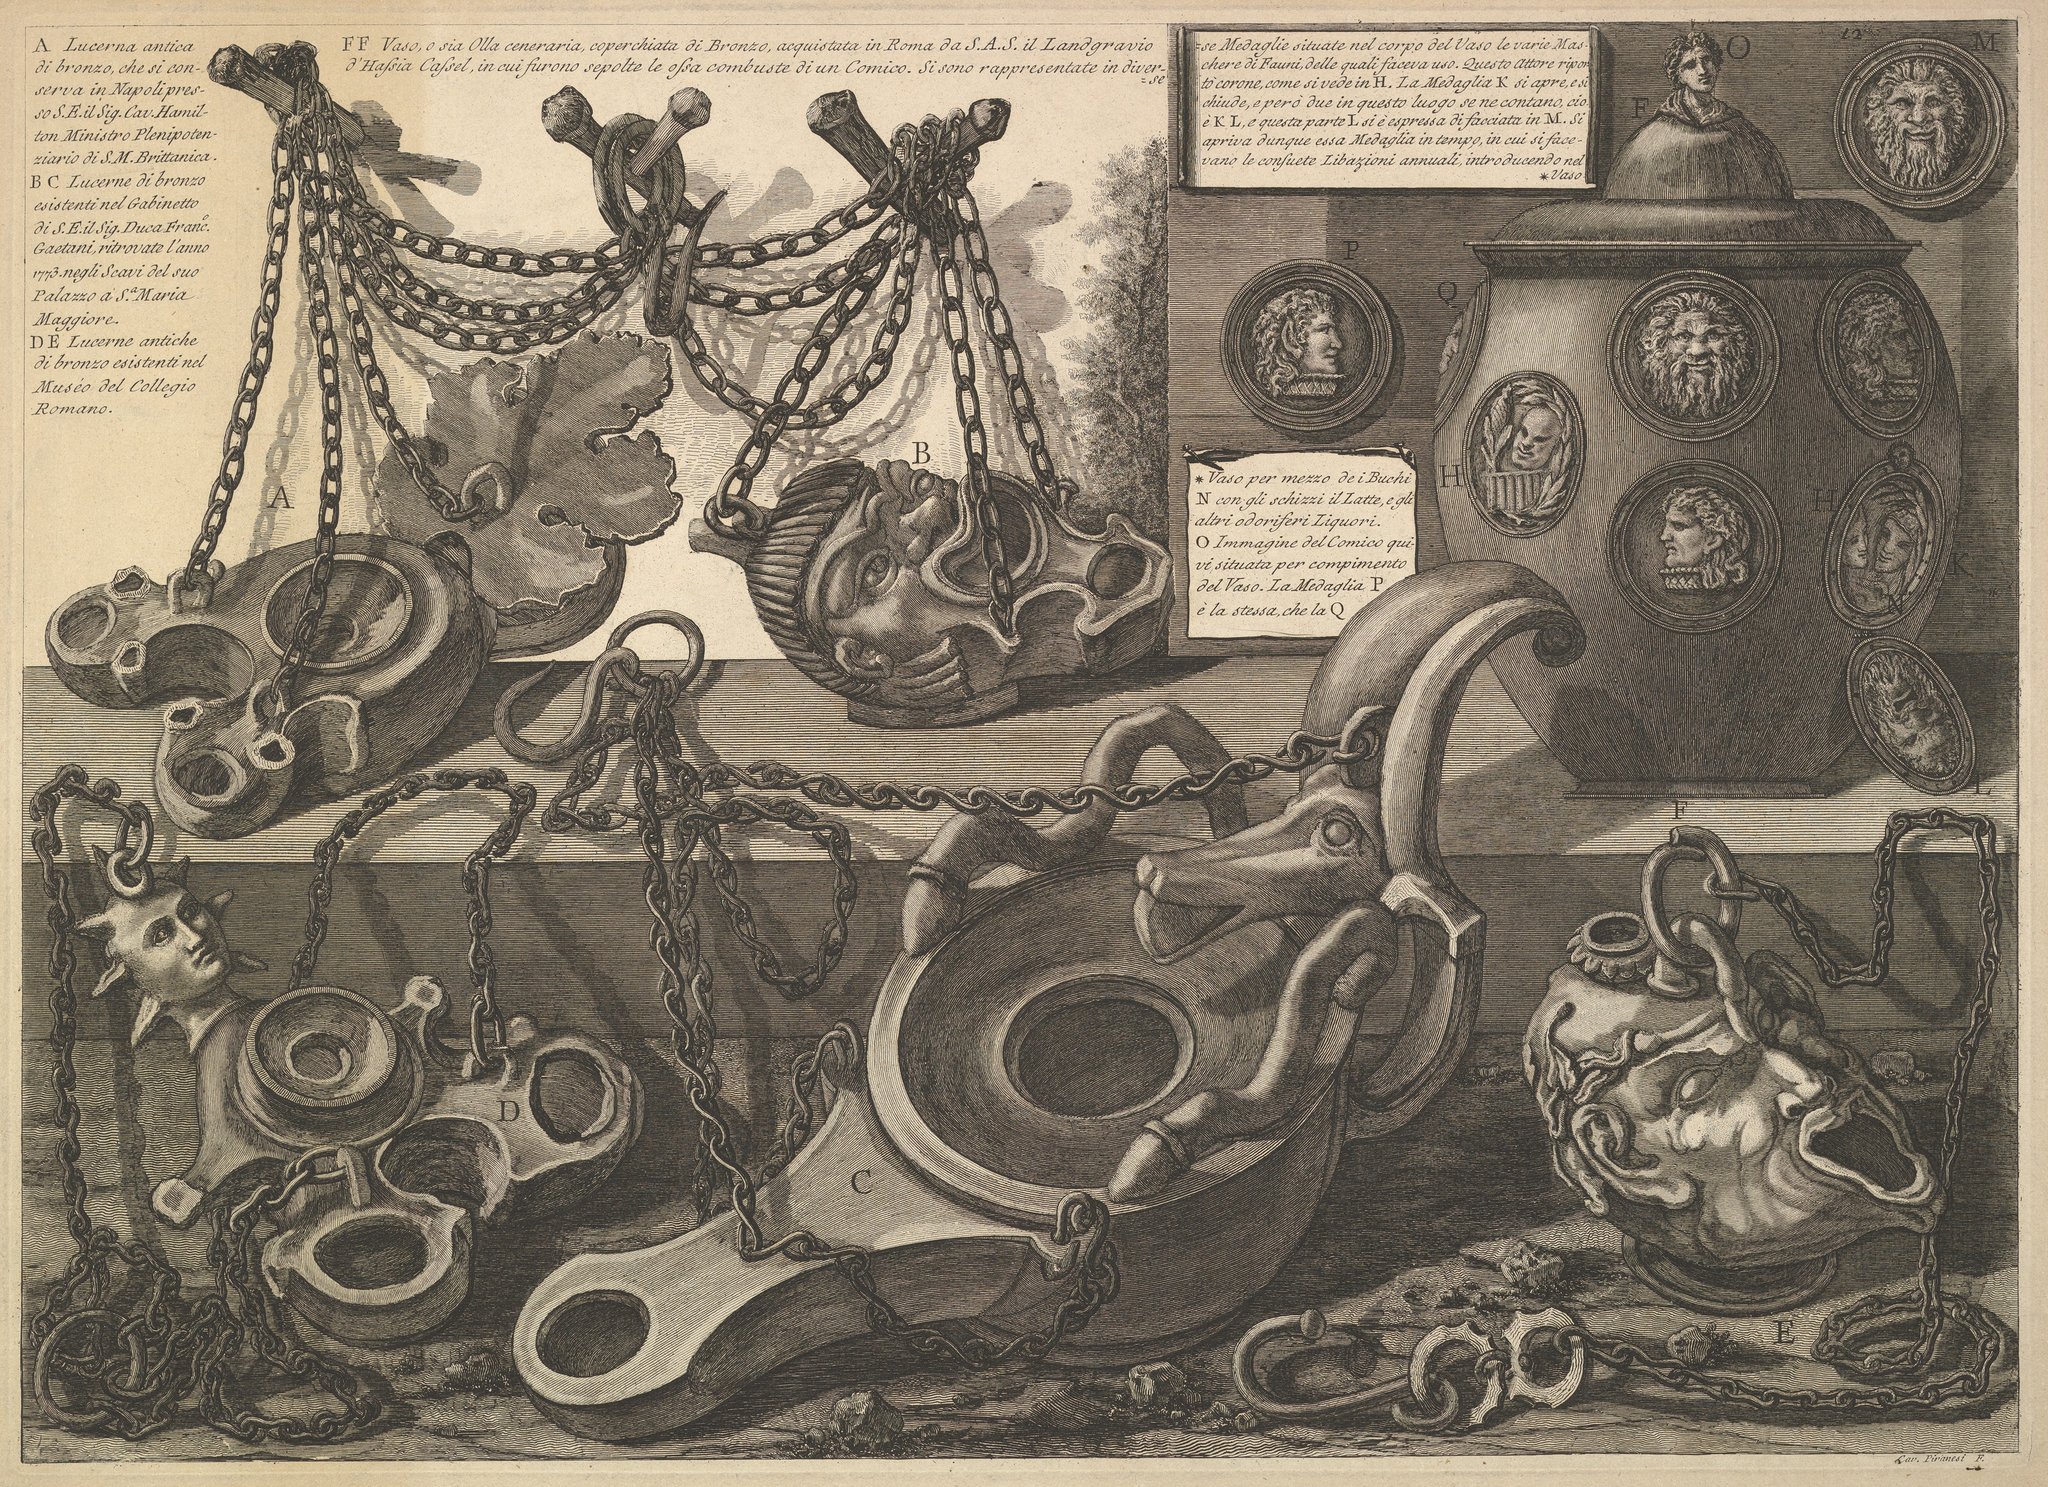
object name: print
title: Various Lamps and a vase encusted with cameos, from "Vasi, candelabri, cippi, sarcofagi, tripodi, lucerne, ed ornamenti antichi disegnati ed incisi dal Cav. Gio. Batt. Piranesi" (Vases, candelabra, grave stones, sarcophagi, tripods, lamps and ornaments designed and etched by Cavaliere Giovanni Battista Piranesi)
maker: giovanni battista piranesi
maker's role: artist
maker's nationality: italian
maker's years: 1720-1778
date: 1778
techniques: etching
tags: lamps,vases